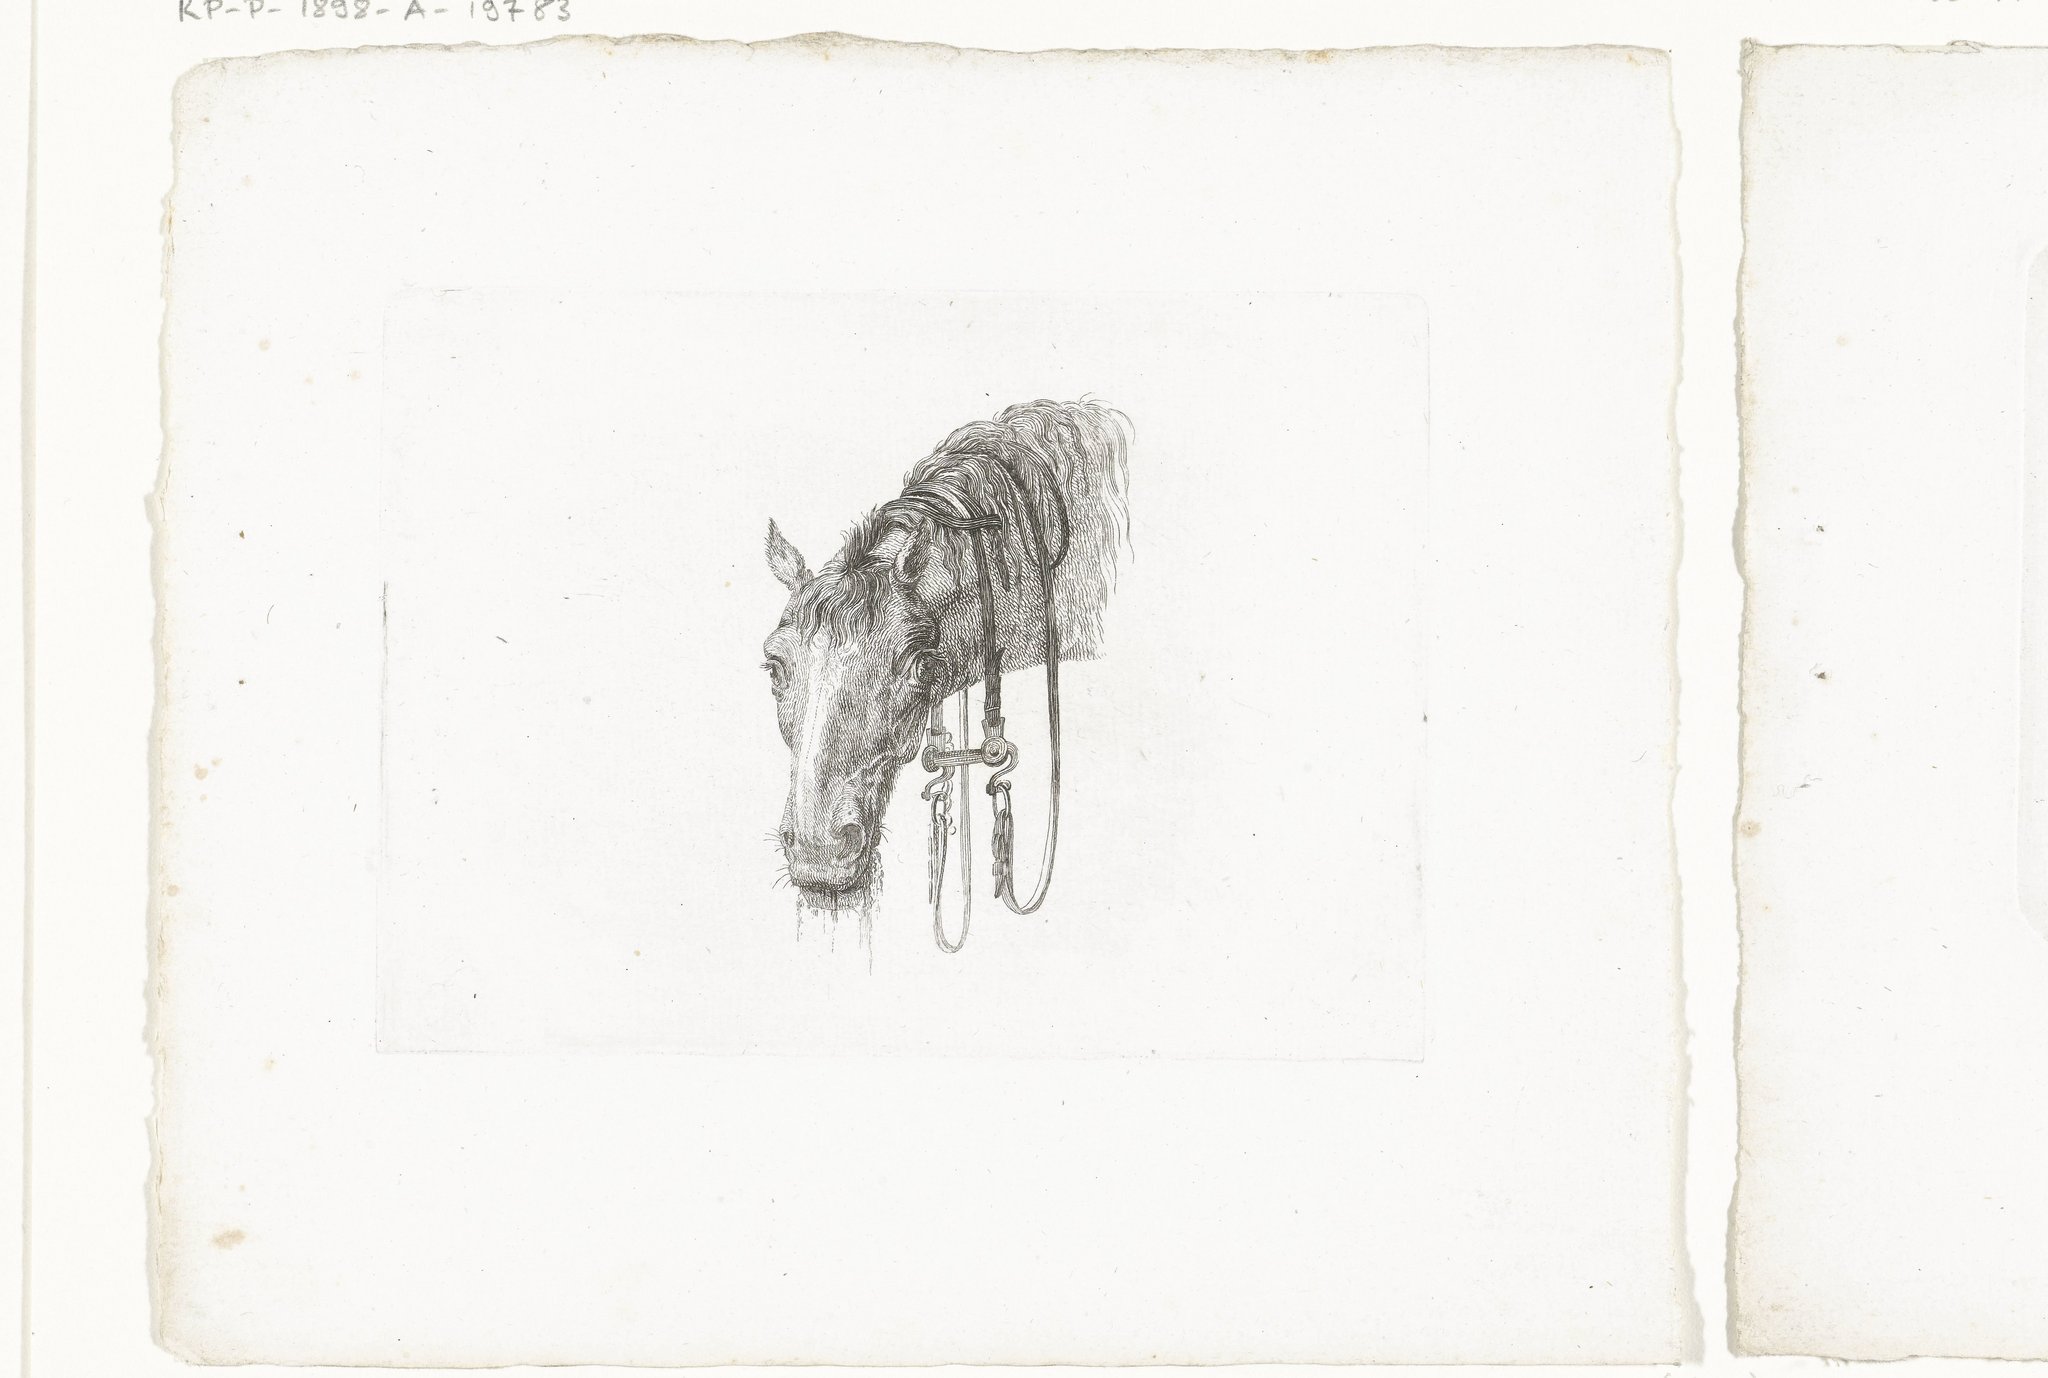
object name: print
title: Paardenhoofd met hangende leidsels, van voren gezien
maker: joannes bemme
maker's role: print maker, printer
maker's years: 1775-1841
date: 1801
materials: paper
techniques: etching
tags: horse (+ head of an animal)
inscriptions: collector's mark: Lugt 2228